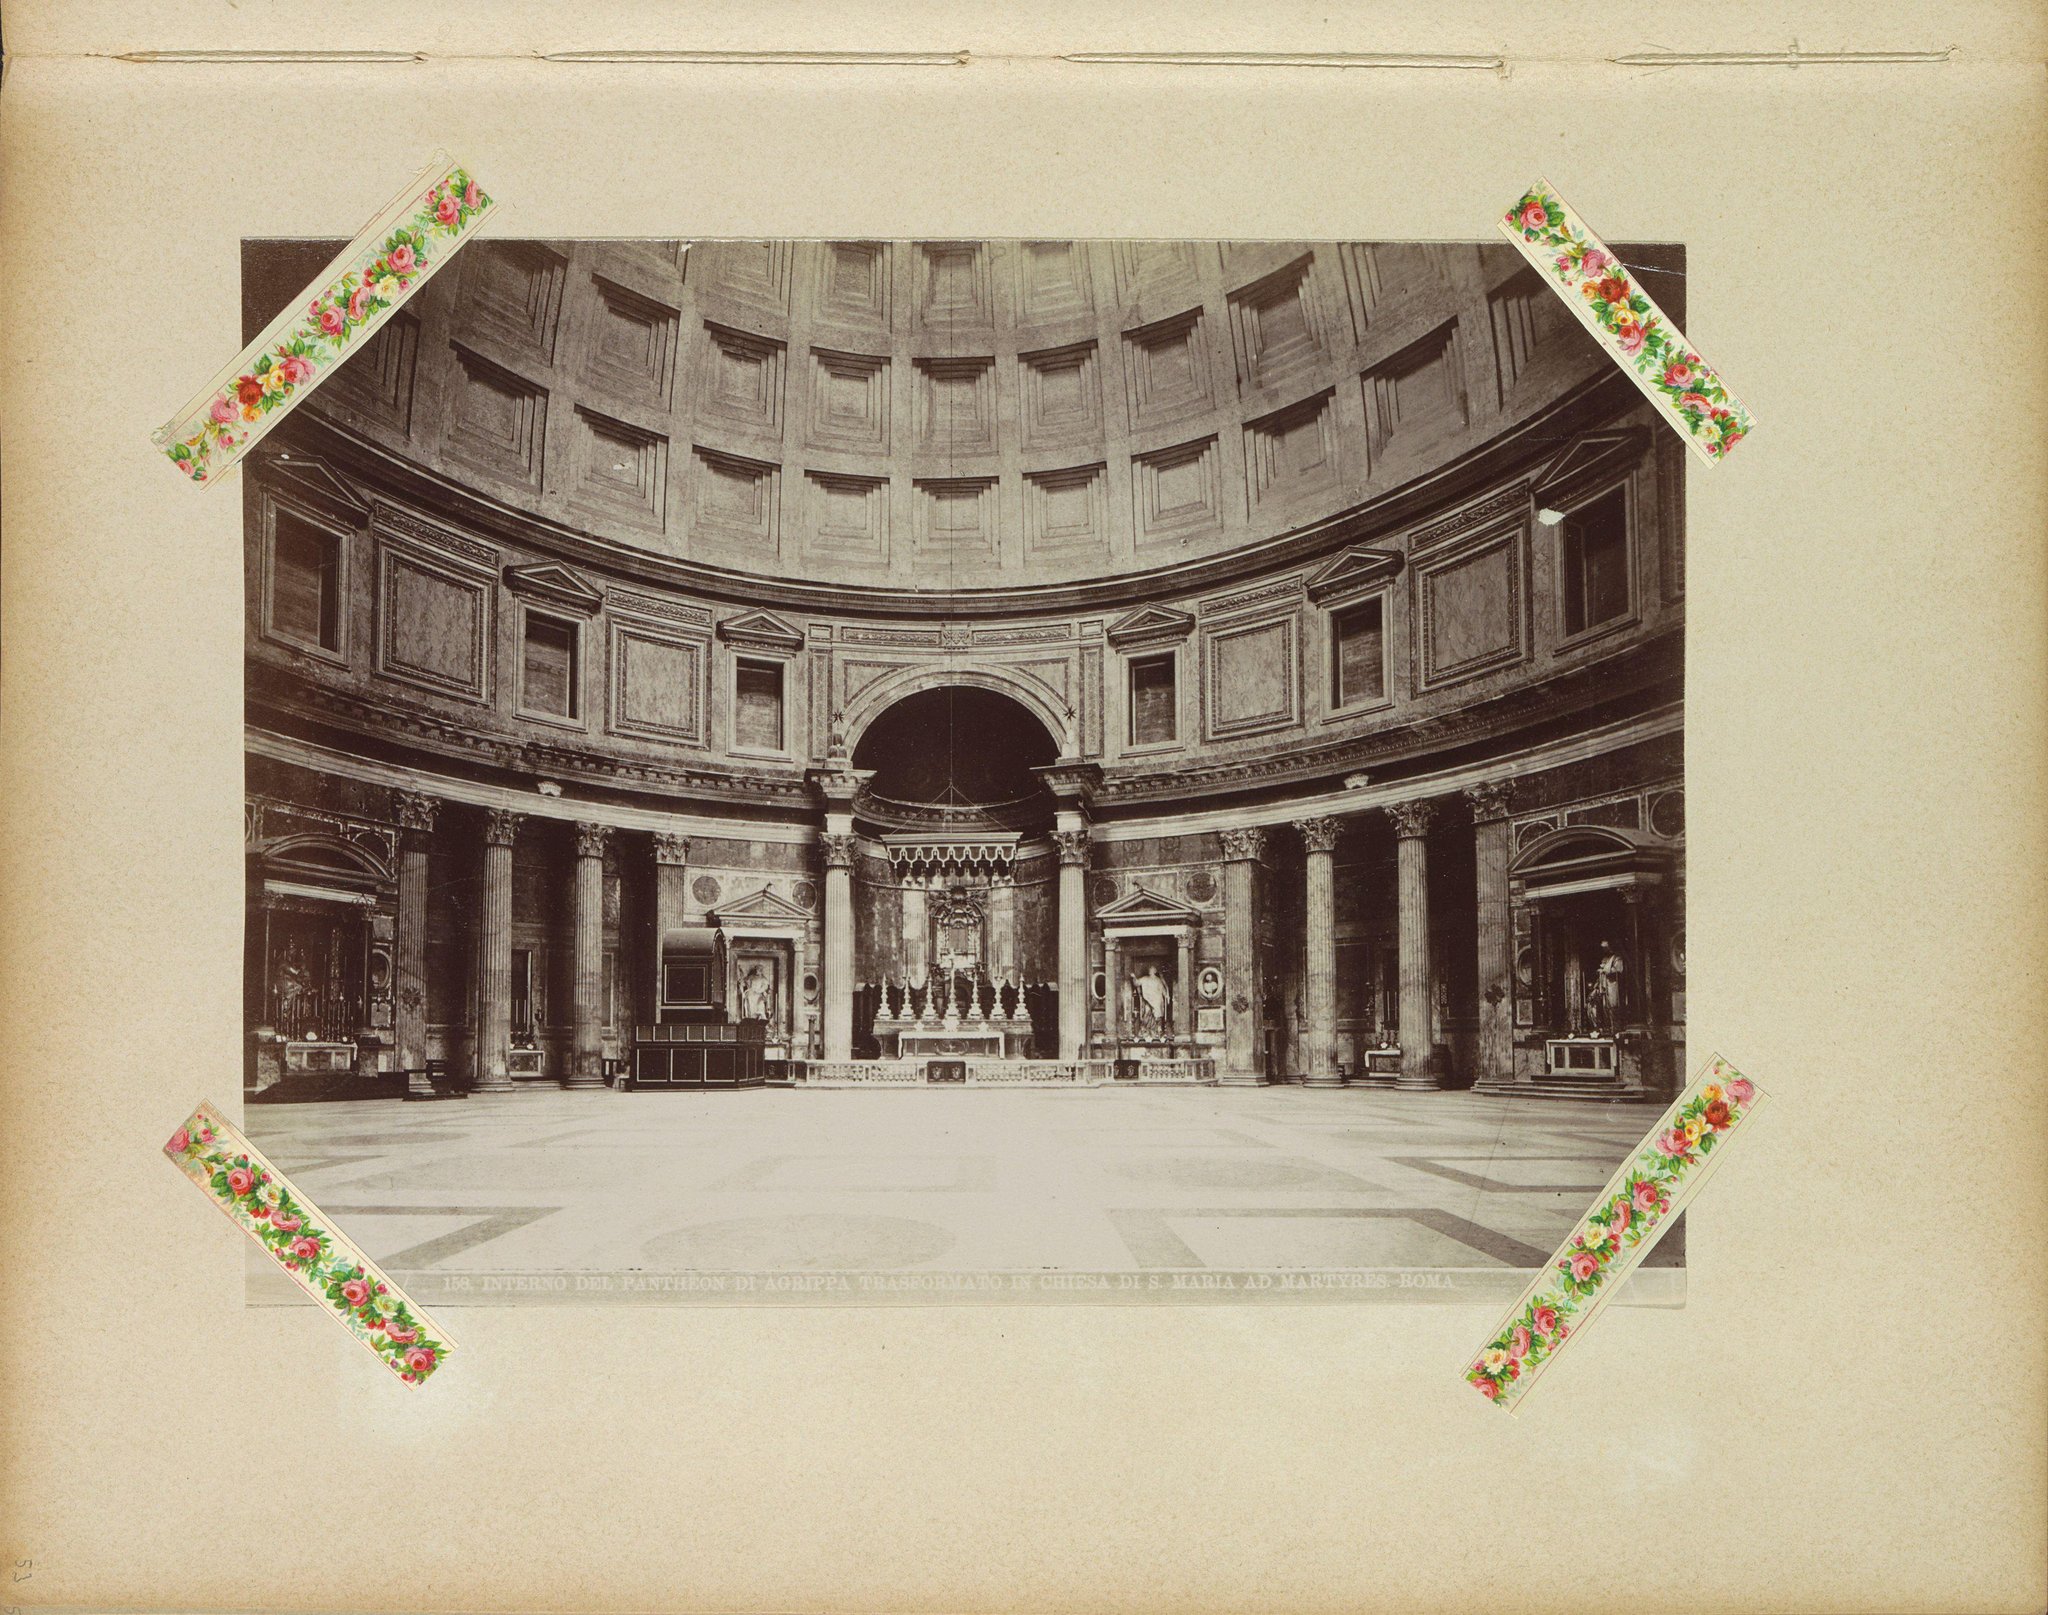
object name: photograph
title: Interno del Pantheon di Agrippa trasformato in Chiesa di S. Maria ad Martyres. Roma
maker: Anonymous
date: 1860-1900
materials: photographic support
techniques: albumen print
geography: pantheon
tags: interior of church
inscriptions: number: ‘158’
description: Onderdeel van Fotoalbum met opnames van bezienswaardigheden in Italiaanse steden en van kunstwerken.